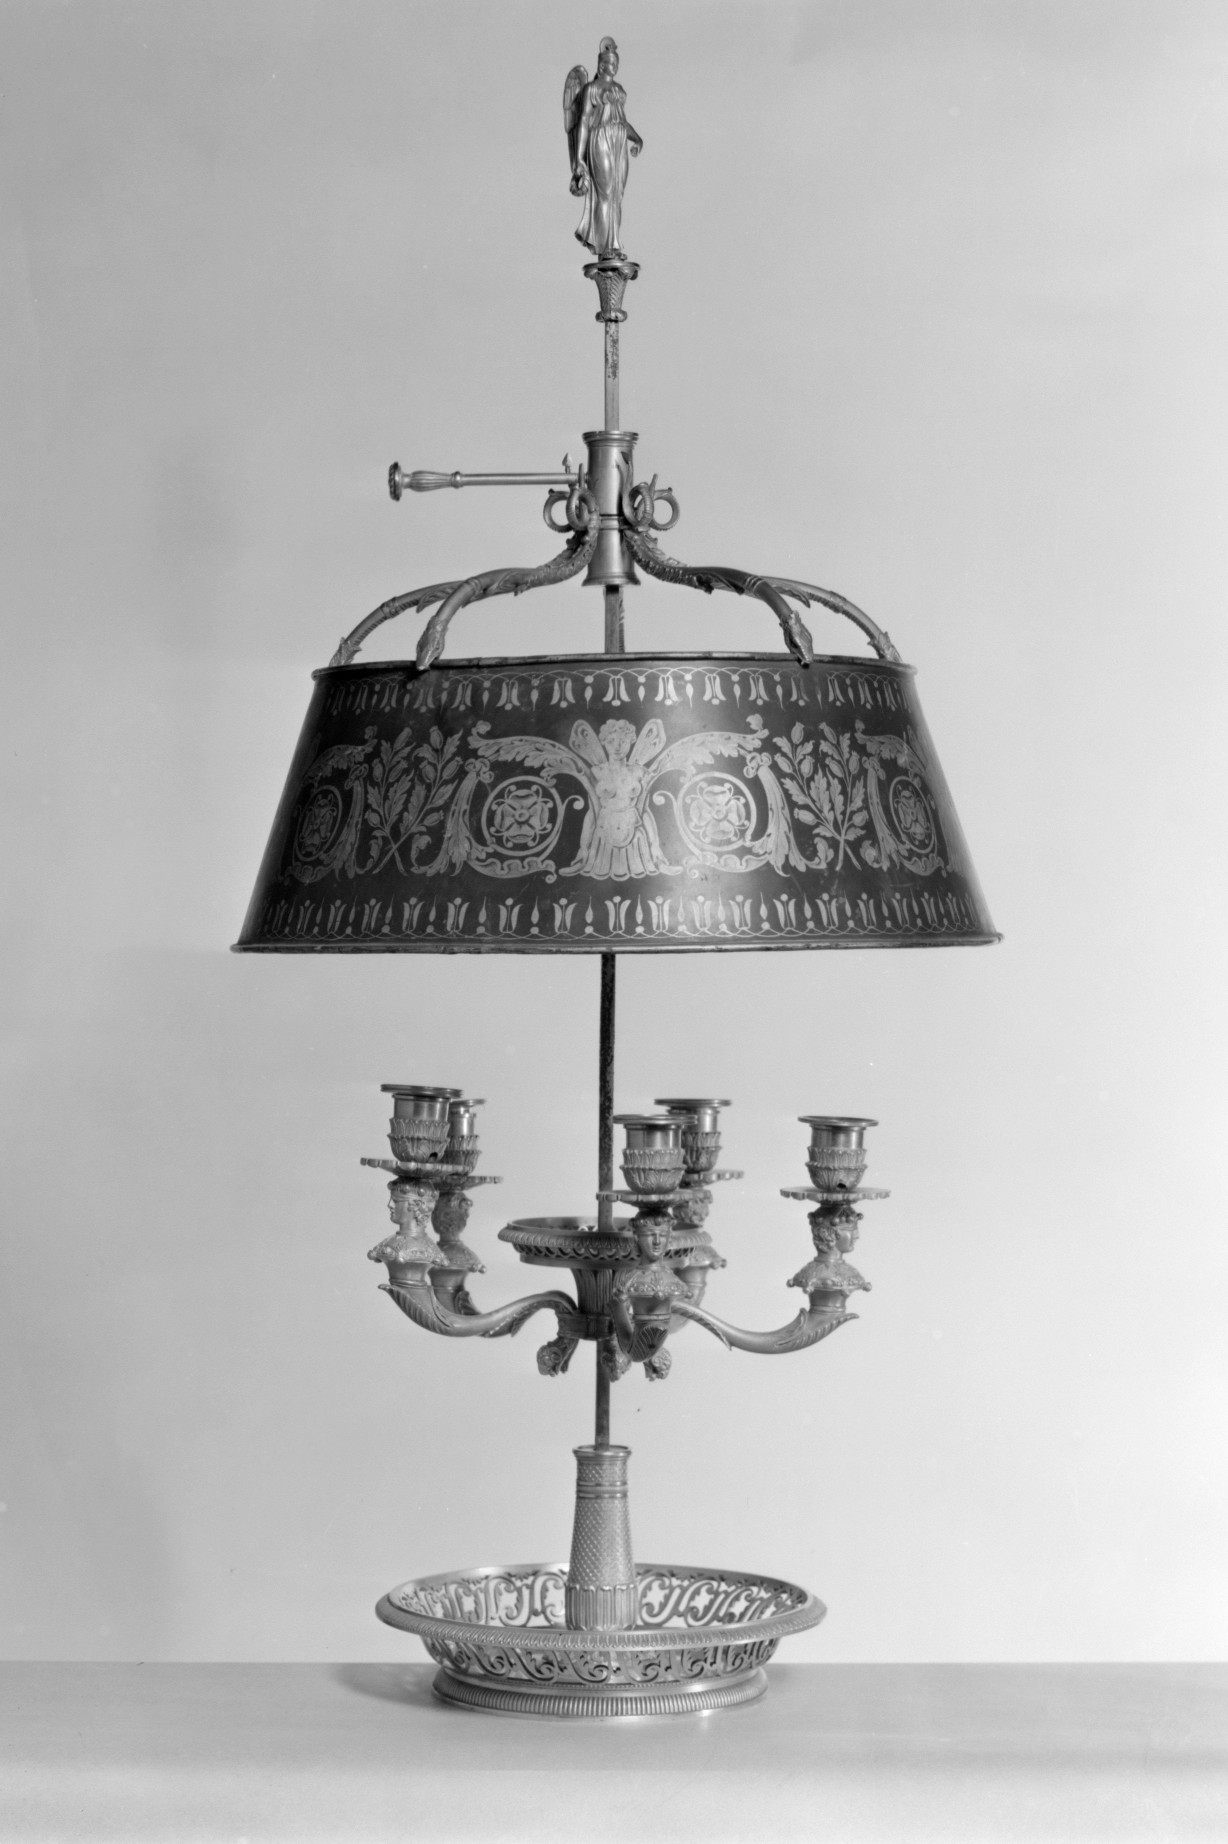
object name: desk candelabrum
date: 1801-1833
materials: gilt bronze